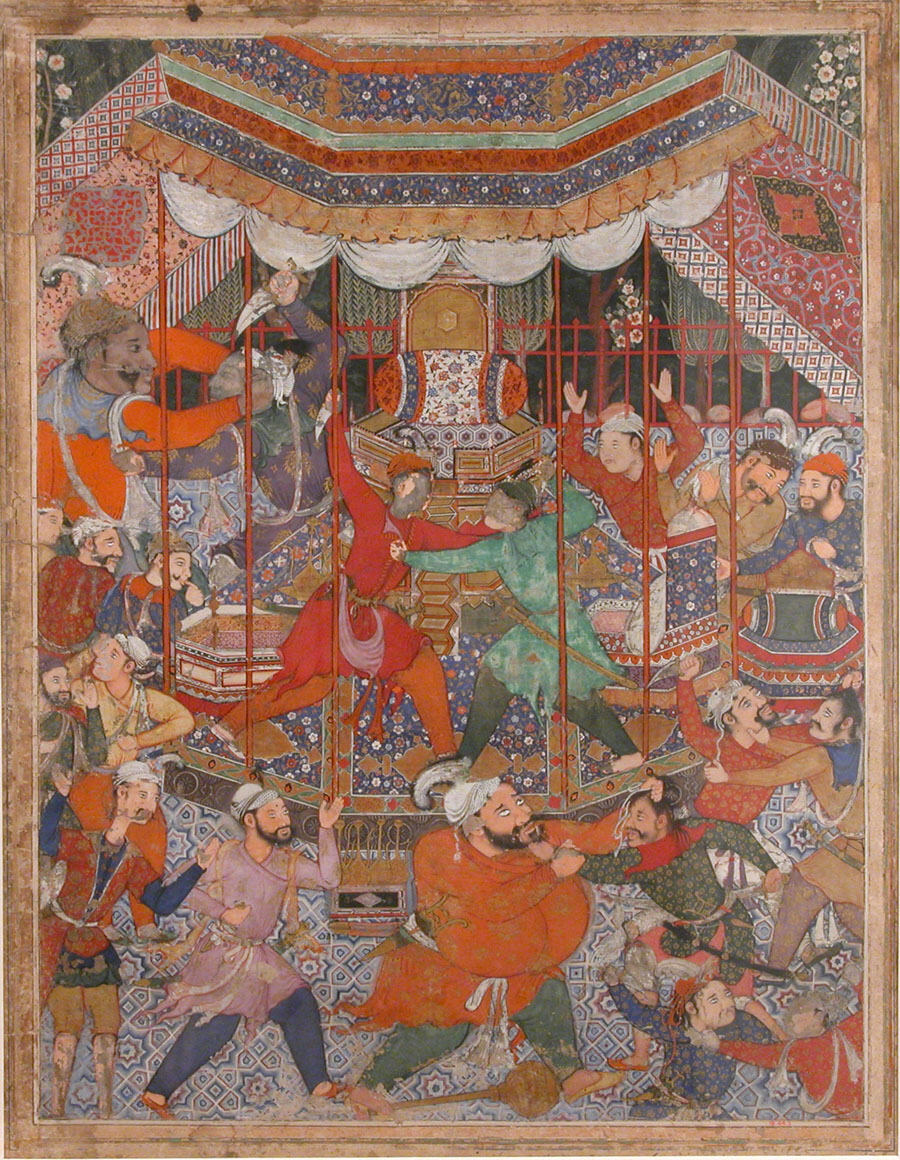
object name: folio from an illustrated manuscript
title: "Hamza's Heroes Fight in Support of Qasim and Badi'uzzaman", Folio from a Hamzanama (The Adventures of Hamza)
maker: shravana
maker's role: artist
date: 1564-1569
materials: textile, gold, ink, paper, watercolor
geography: india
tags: battles,men